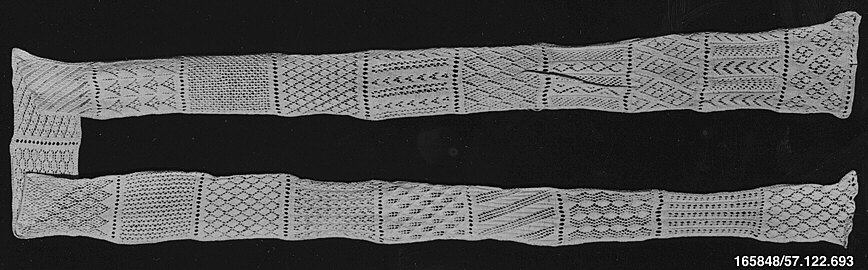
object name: sampler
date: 1801-1900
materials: lace, wool